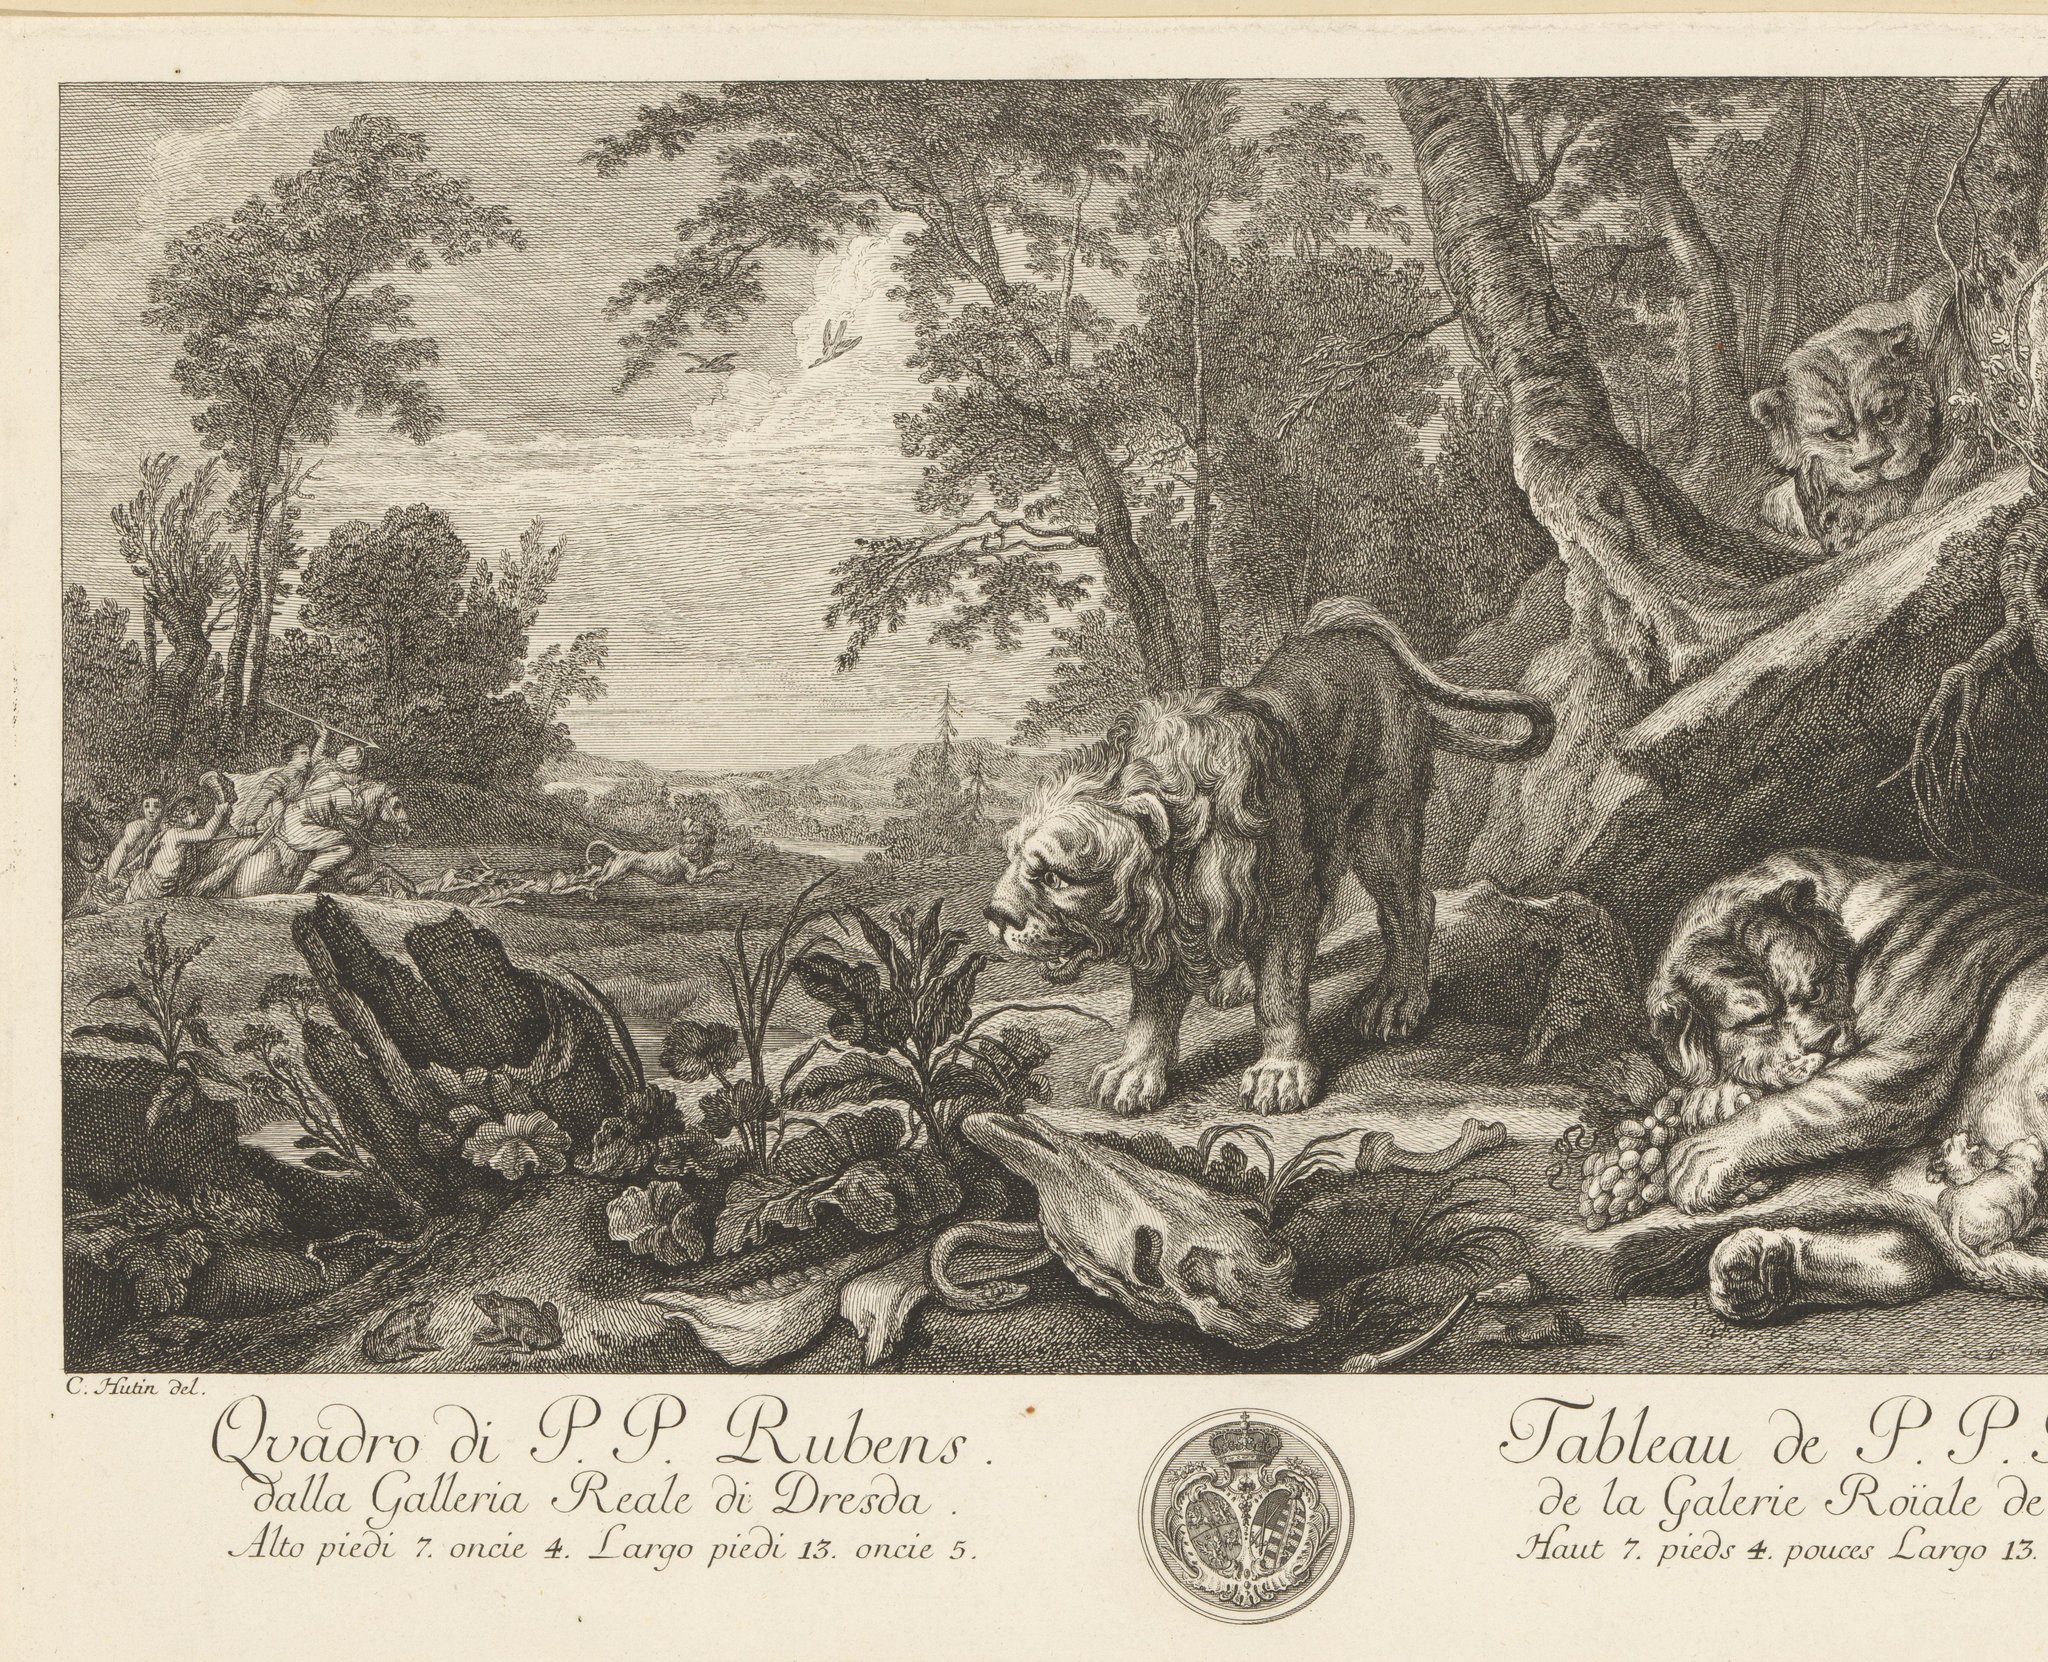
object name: print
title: Groep leeuwen en een leeuwenjacht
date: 1708-1767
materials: paper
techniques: etching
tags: lion's den, tailless amphibians: frog, lion hunt, beasts of prey, predatory animals: lion, armorial bearing, heraldry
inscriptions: collector's mark: Lugt 240, collector's mark: Lugt 1838